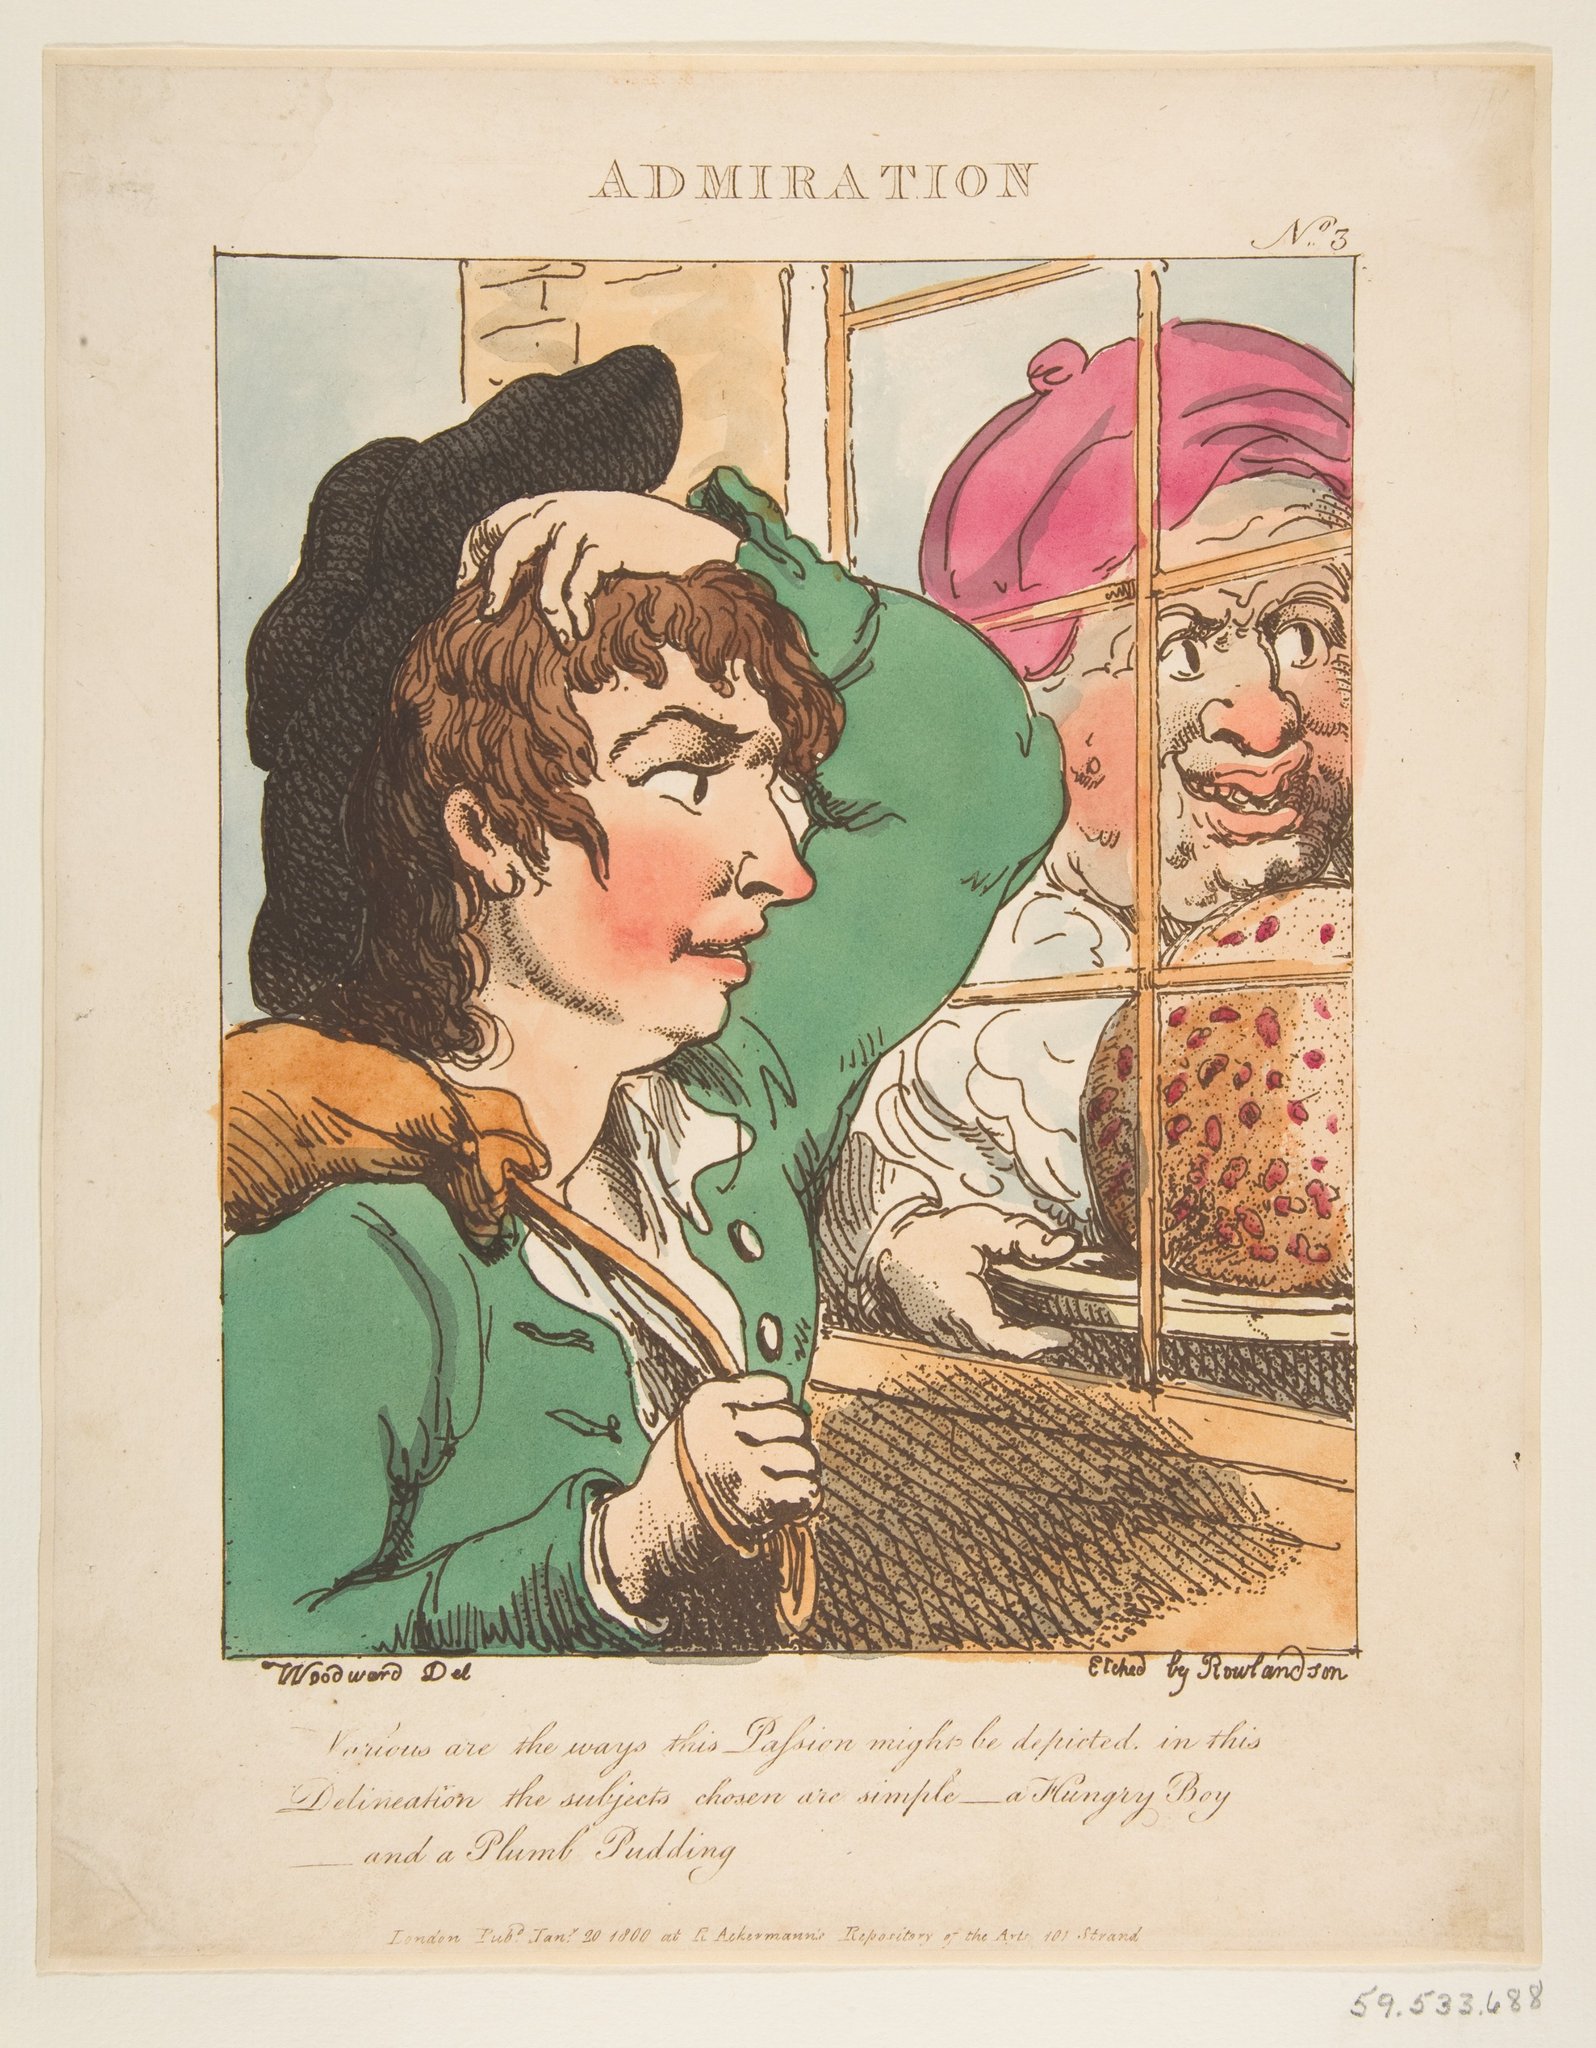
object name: print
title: Admiration (Le Brun Travested, or Caricatures of the Passions)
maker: thomas rowlandson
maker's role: artist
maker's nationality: british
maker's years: 1757-1827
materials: ink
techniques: etching, hand coloring, printing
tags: food,satire,boys,men